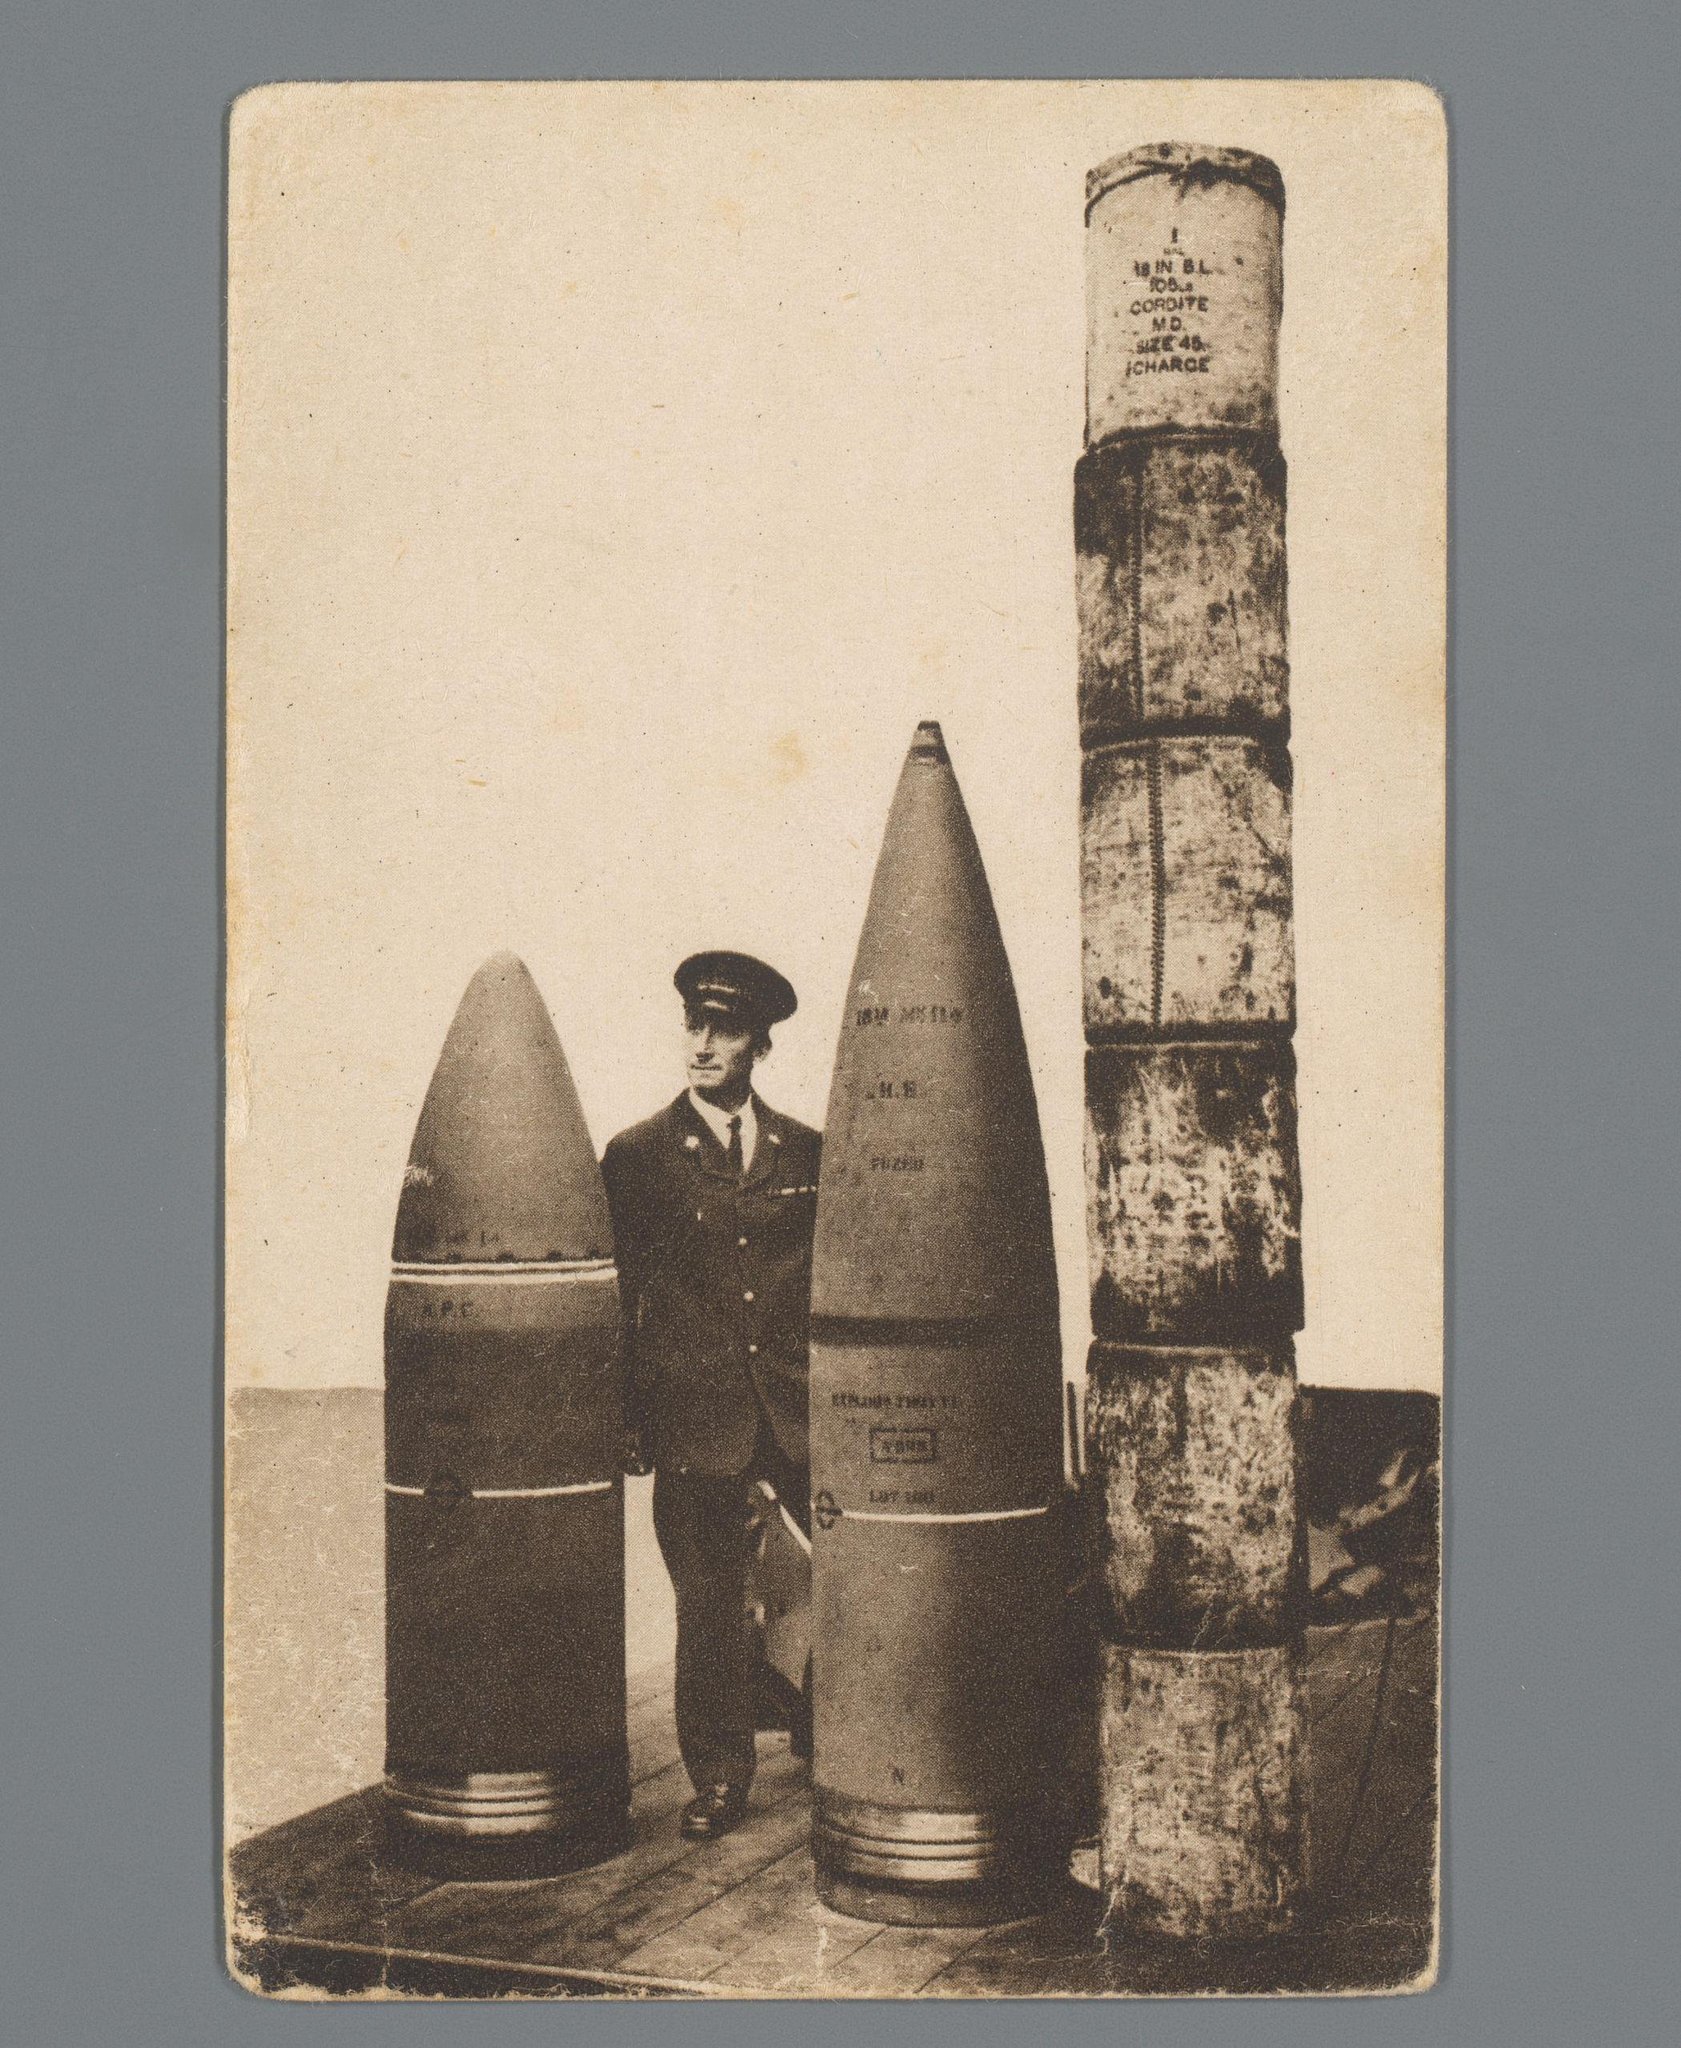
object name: photomechanical print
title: Britse marinier staande naast munitie en enkele projectielen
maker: Anonymous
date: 1918-1970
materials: paper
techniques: rotogravure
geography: great britain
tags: projectiles, explosives, etc.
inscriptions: inscription: ‘Crown Copyright in letterpress and illustrations reserved.’